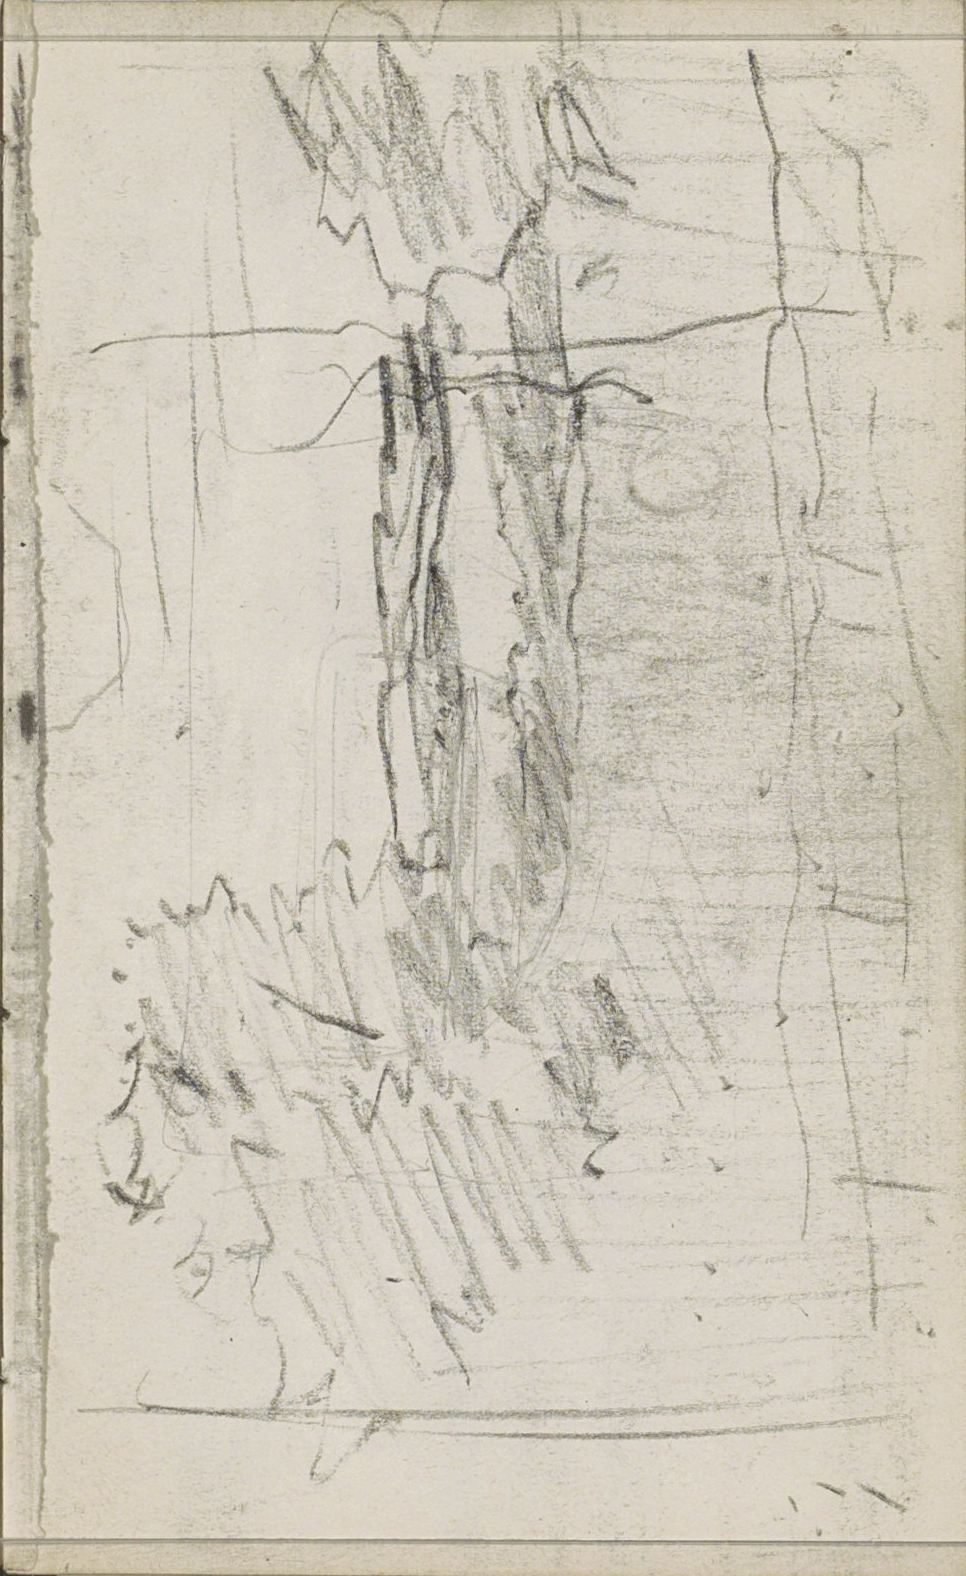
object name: sketchbook leaf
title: Landschap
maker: anton mauve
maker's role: draughtsman, painter, print maker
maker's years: 1838-1888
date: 1848-1888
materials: chalk, paper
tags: landscapes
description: Blad 17 recto uit een schetsboek met 53 bladen.